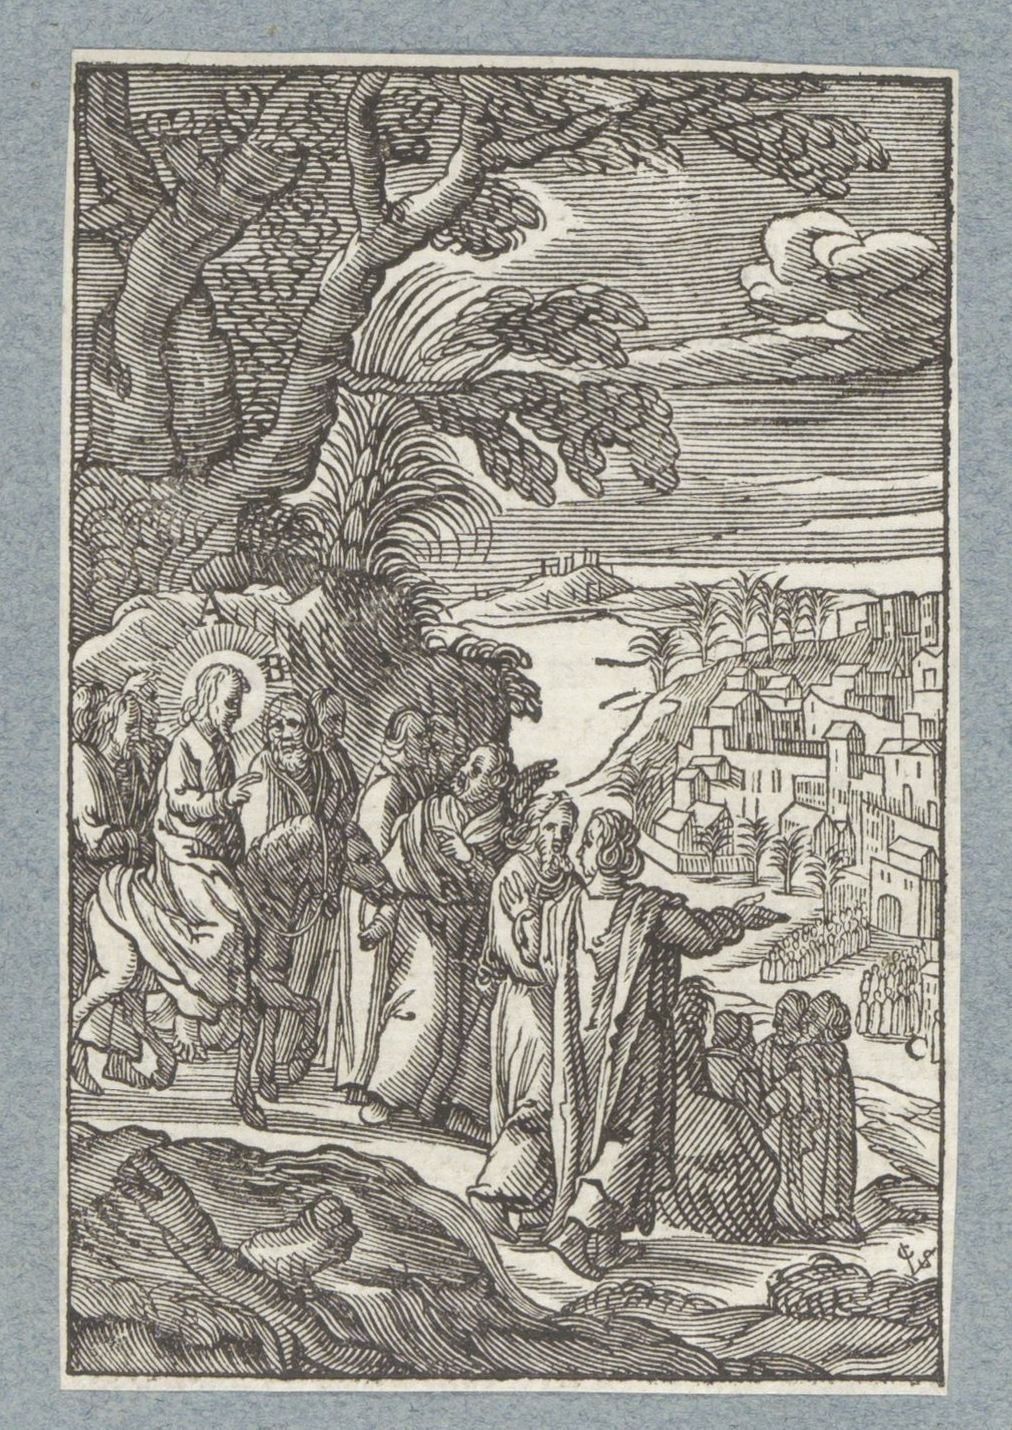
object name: print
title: Intocht in Jeruzalem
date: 1629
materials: paper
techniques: letterpress printing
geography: amsterdam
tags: entry into jerusalem: people spreading their clothes before christ on the ass, and waving palm branches (matthew 21:1-11, 21:14-16; mark 11:1-11; luke 19:28-40; john 12:12-19)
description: De prent is afkomstig uit een van de uitgaven van P.J. Paets uit Amsterdam. Ze wordt voor het eerst gebruikt in: Der Zielen Lust-hof. Leuven, I.Jacbosz voor P.J. Paets [= Amsterdam, P.J. Paets], 1629. De voorstelling is gekopieerd naar een prent van Hieronymus Wierix voor: Nadal, Jerónimo. Evangelicae Historiae Imagines. Antwerpen, M. Nutius, 1593.